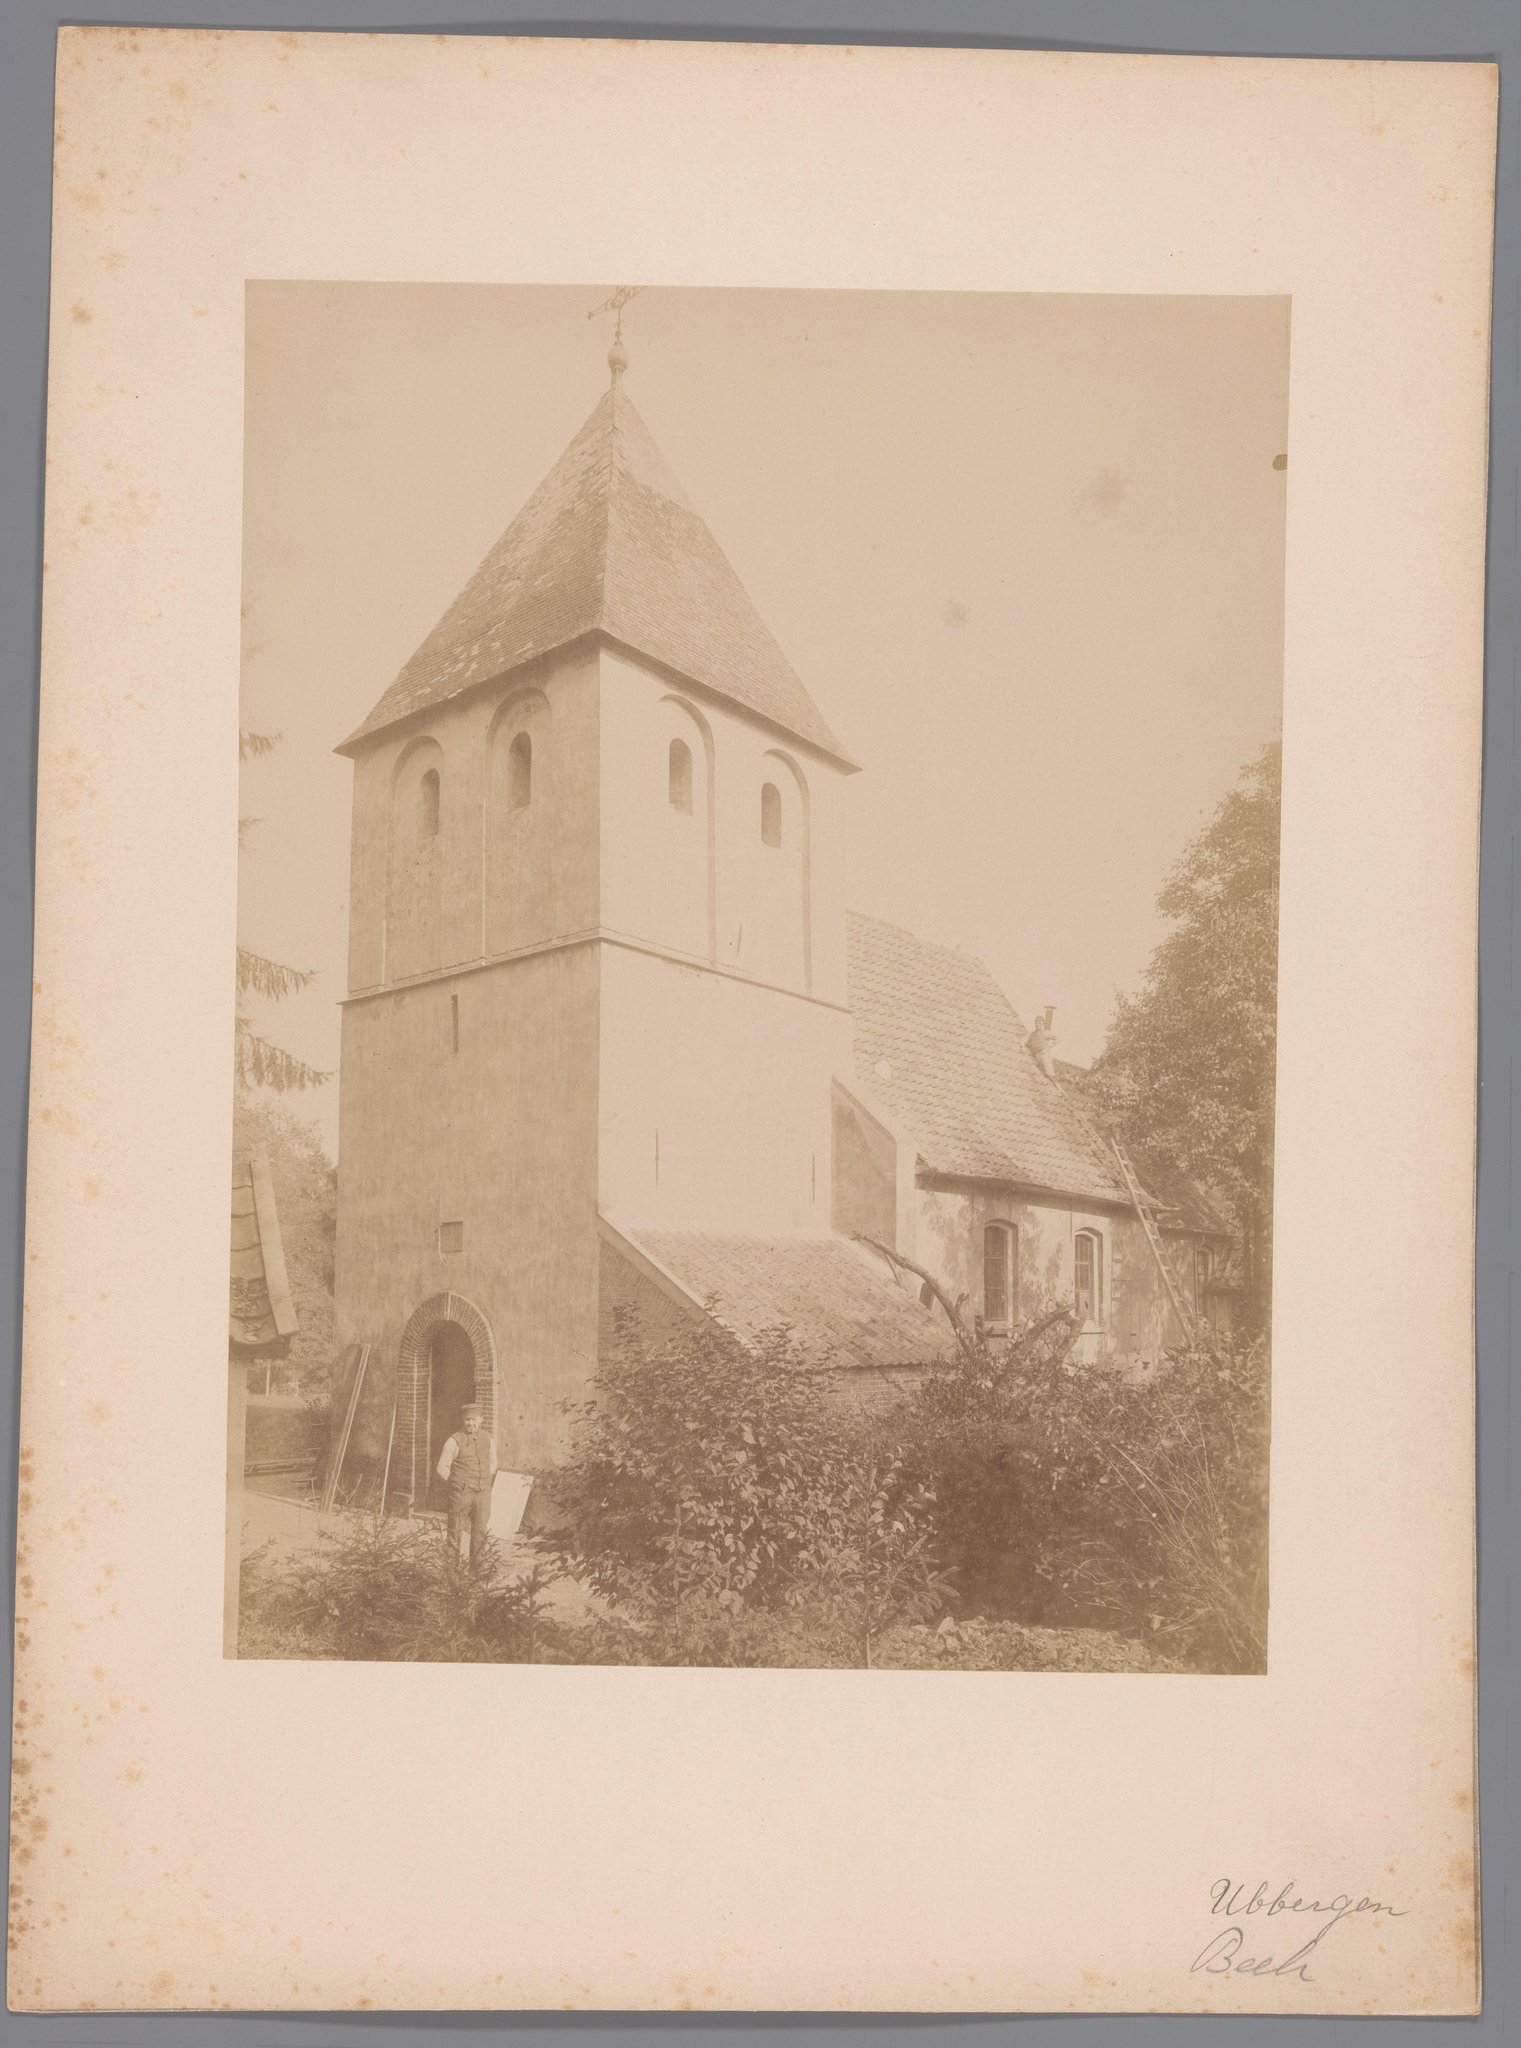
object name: photograph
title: Toren van het Kleine Bartholomeuskerkje te Beek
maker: anoniem (monumentenzorg)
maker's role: fotograaf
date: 1895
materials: cardboard, photographic support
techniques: albumen print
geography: beek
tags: parts of church exterior and annexes: tower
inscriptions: annotation: ‘Ubbergen/ Beek’, annotation: ‘Ned. Herv. kerk te Beek bij Nijmegen/ oct 1895’